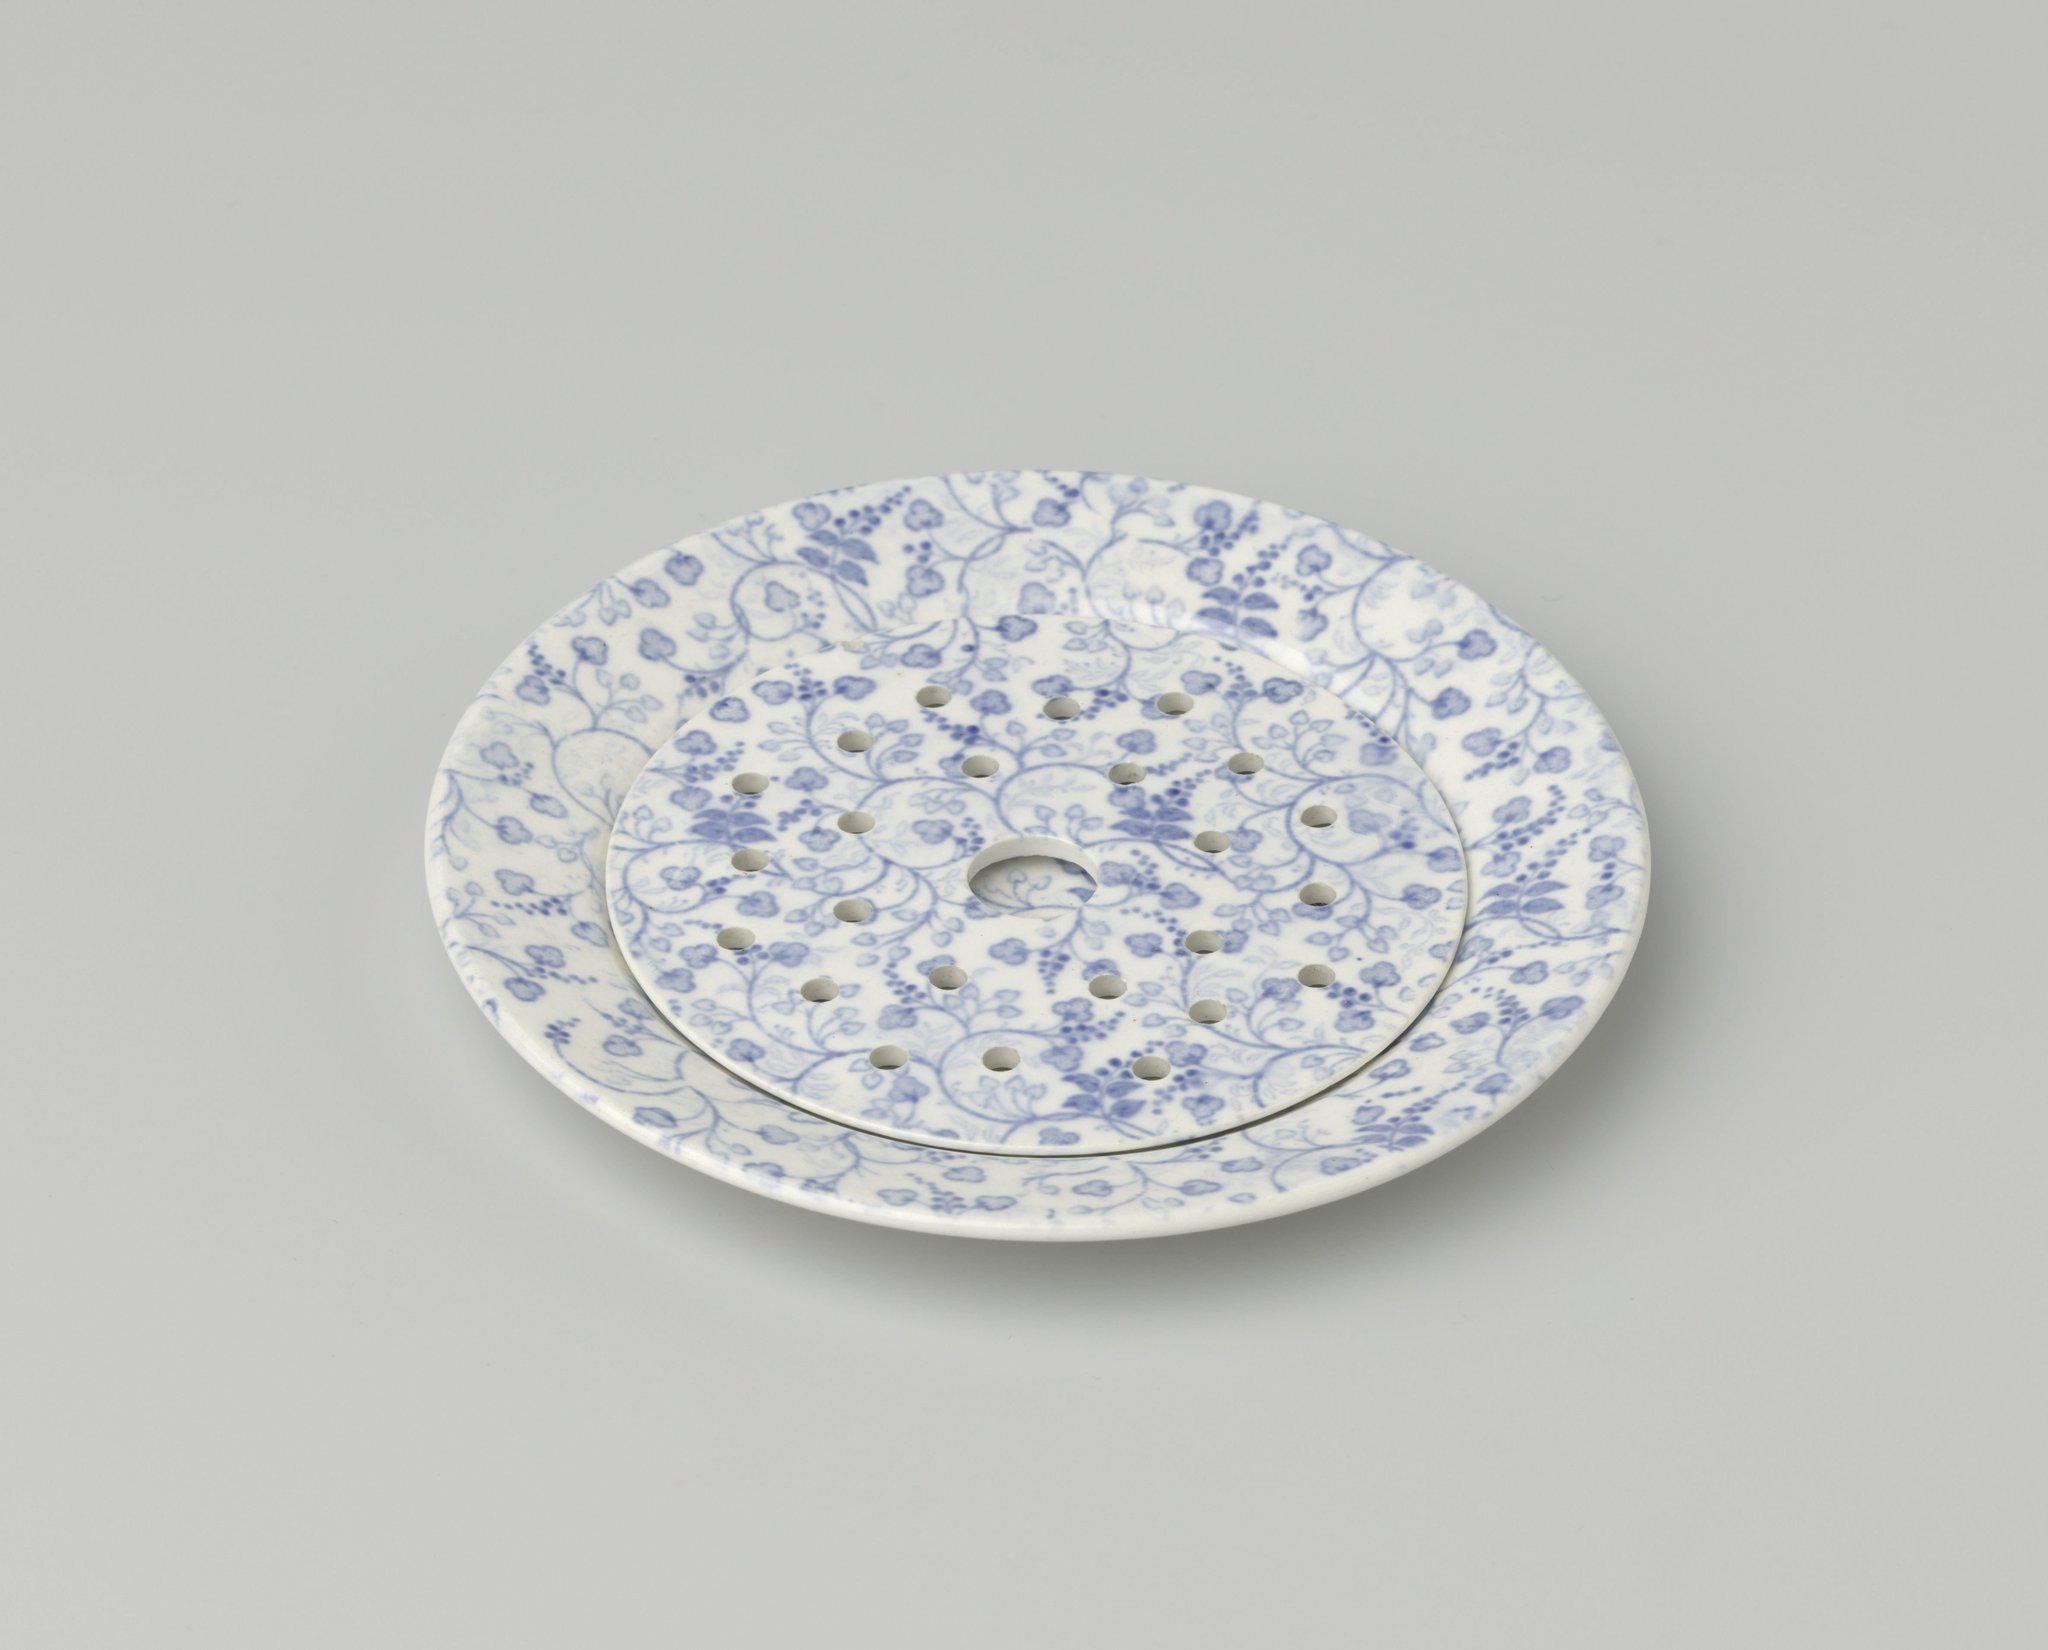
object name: trivet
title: Schotel met treeft, rond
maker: petrus regout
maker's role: plateelbakker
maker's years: 1801-1879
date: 1867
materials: creamware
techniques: transfer decoration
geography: maastricht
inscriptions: check stamp: ‘PR // 2 45’, check stamp: ‘PR 24’, mark: ‘PARSEME No 3’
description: Schotel met treeft van aardewerk, rond, met blauw doorlopend bloemendecor, behorend tot een kinderservies. De treeft heeft vijfentwintig gaten.